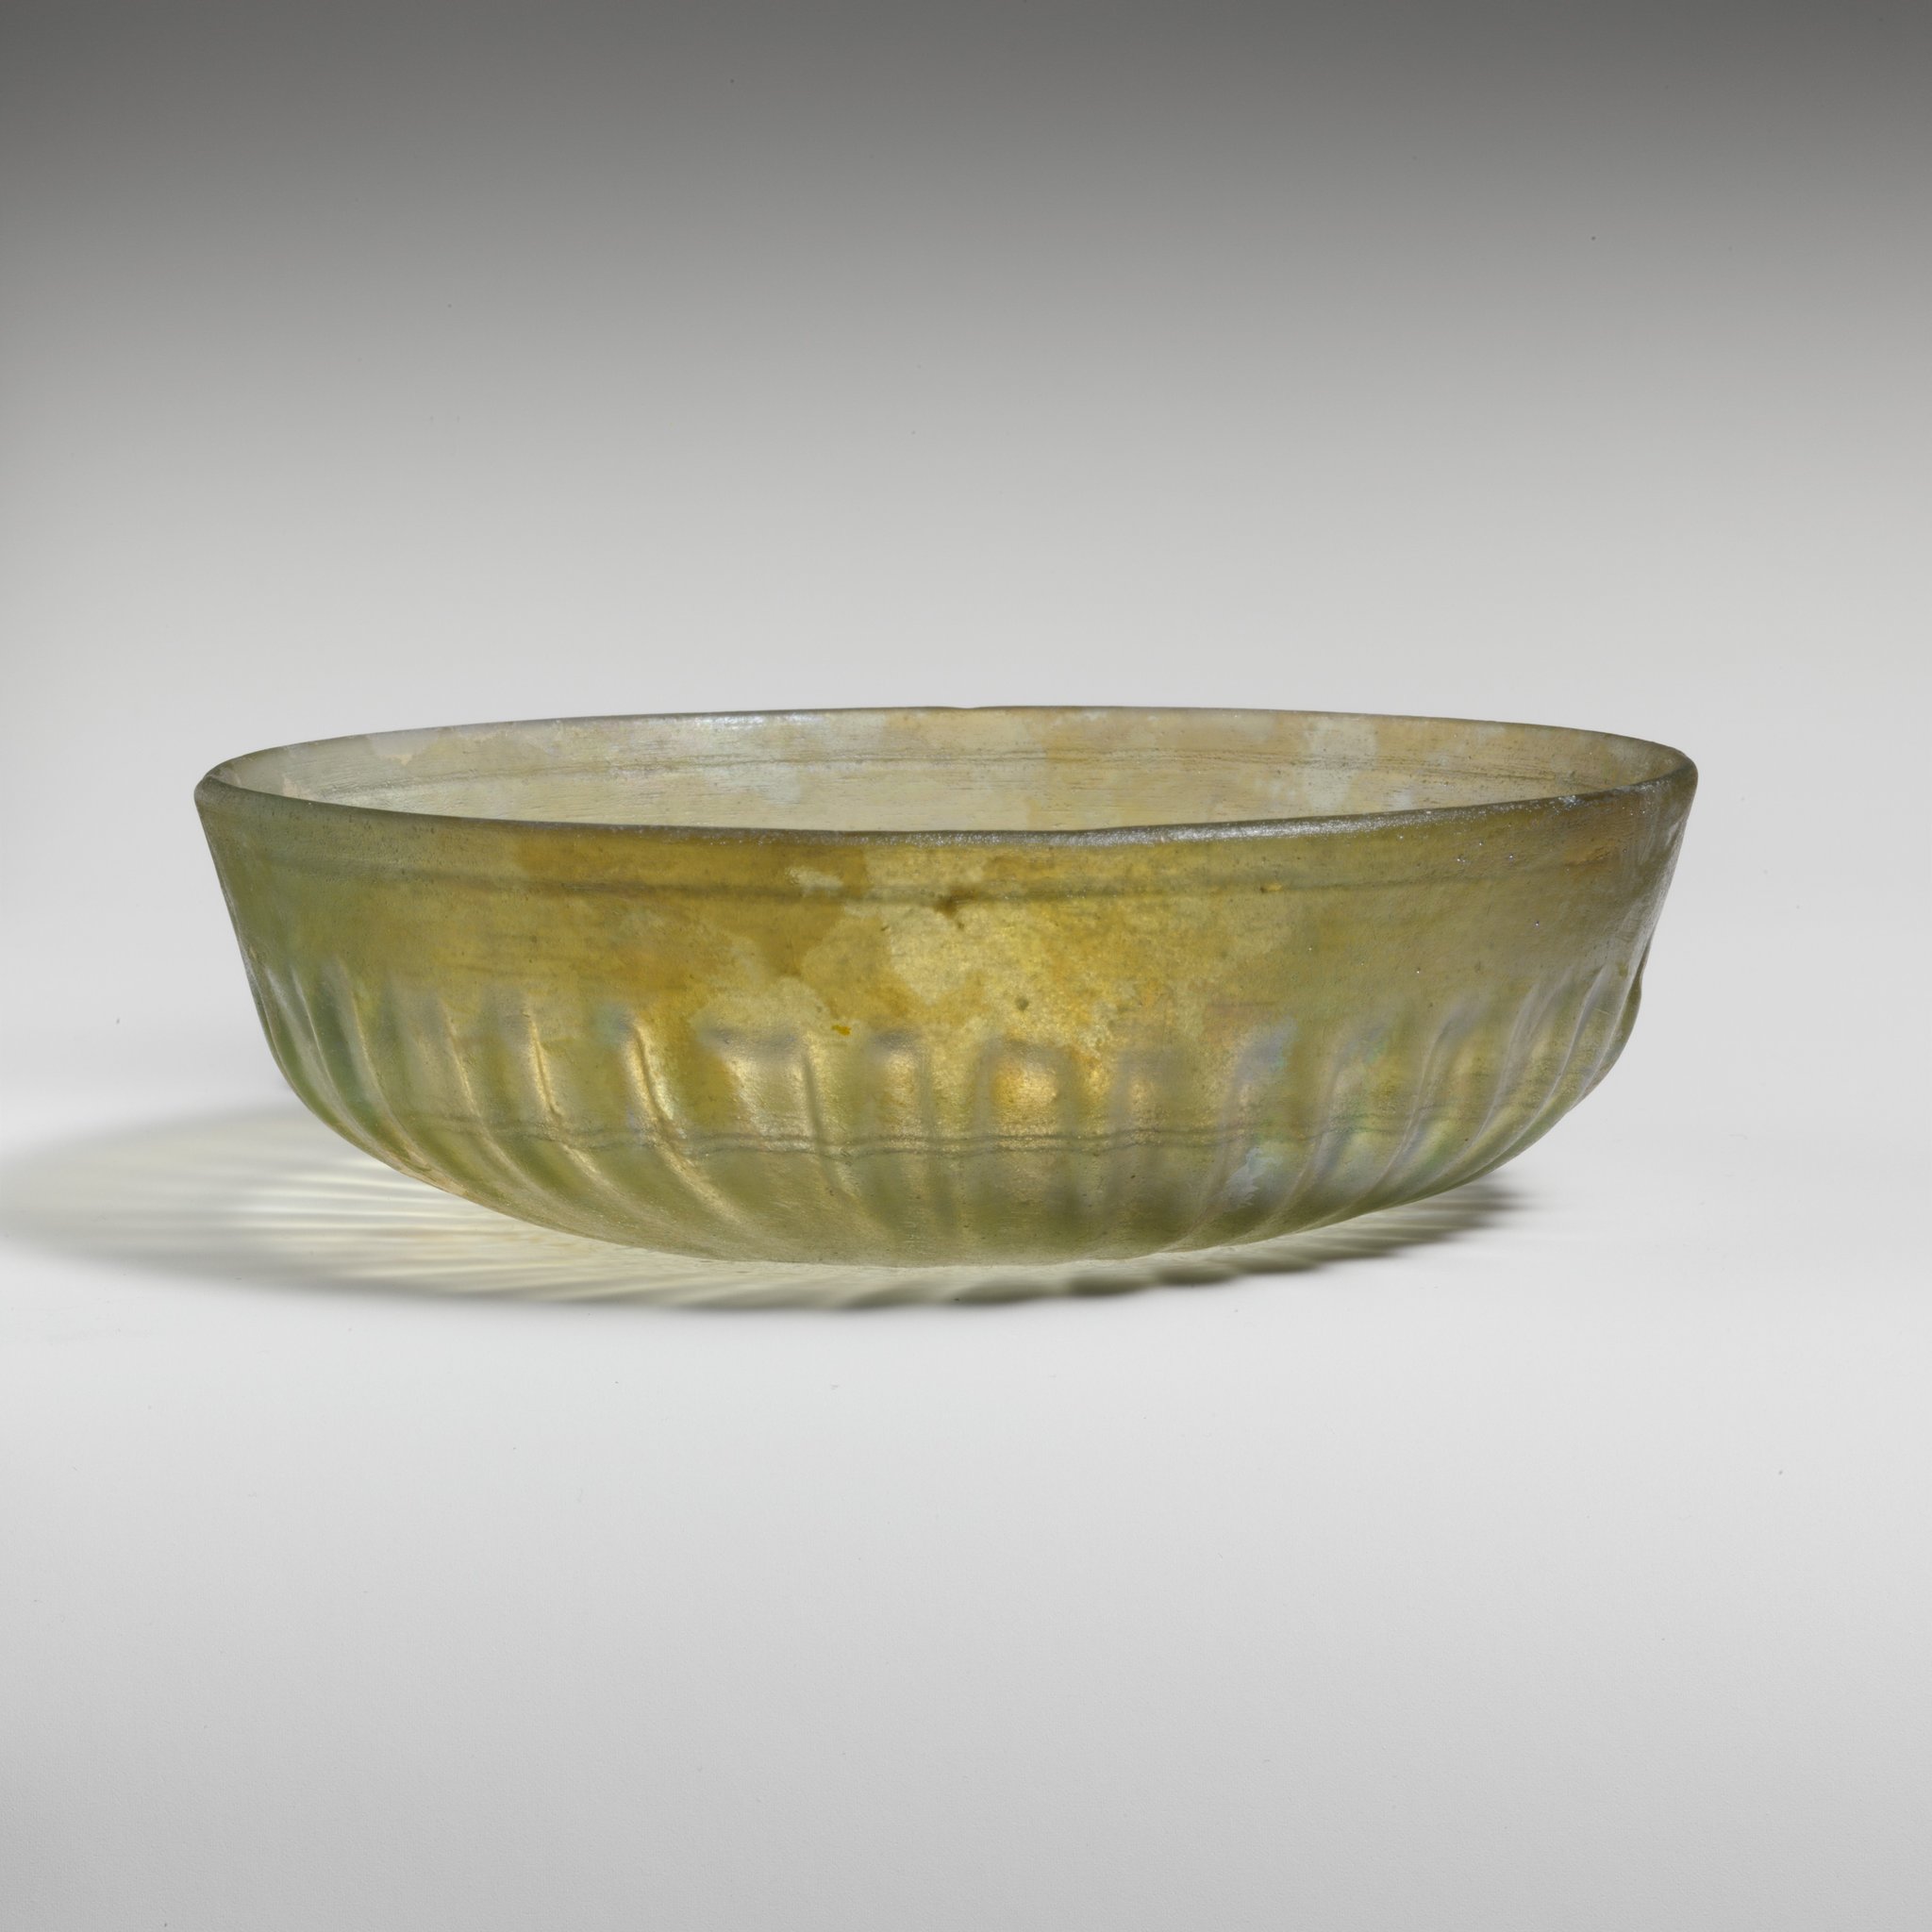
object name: bowl, ribbed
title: Glass ribbed bowl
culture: roman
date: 34 BCE-66 CE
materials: glass